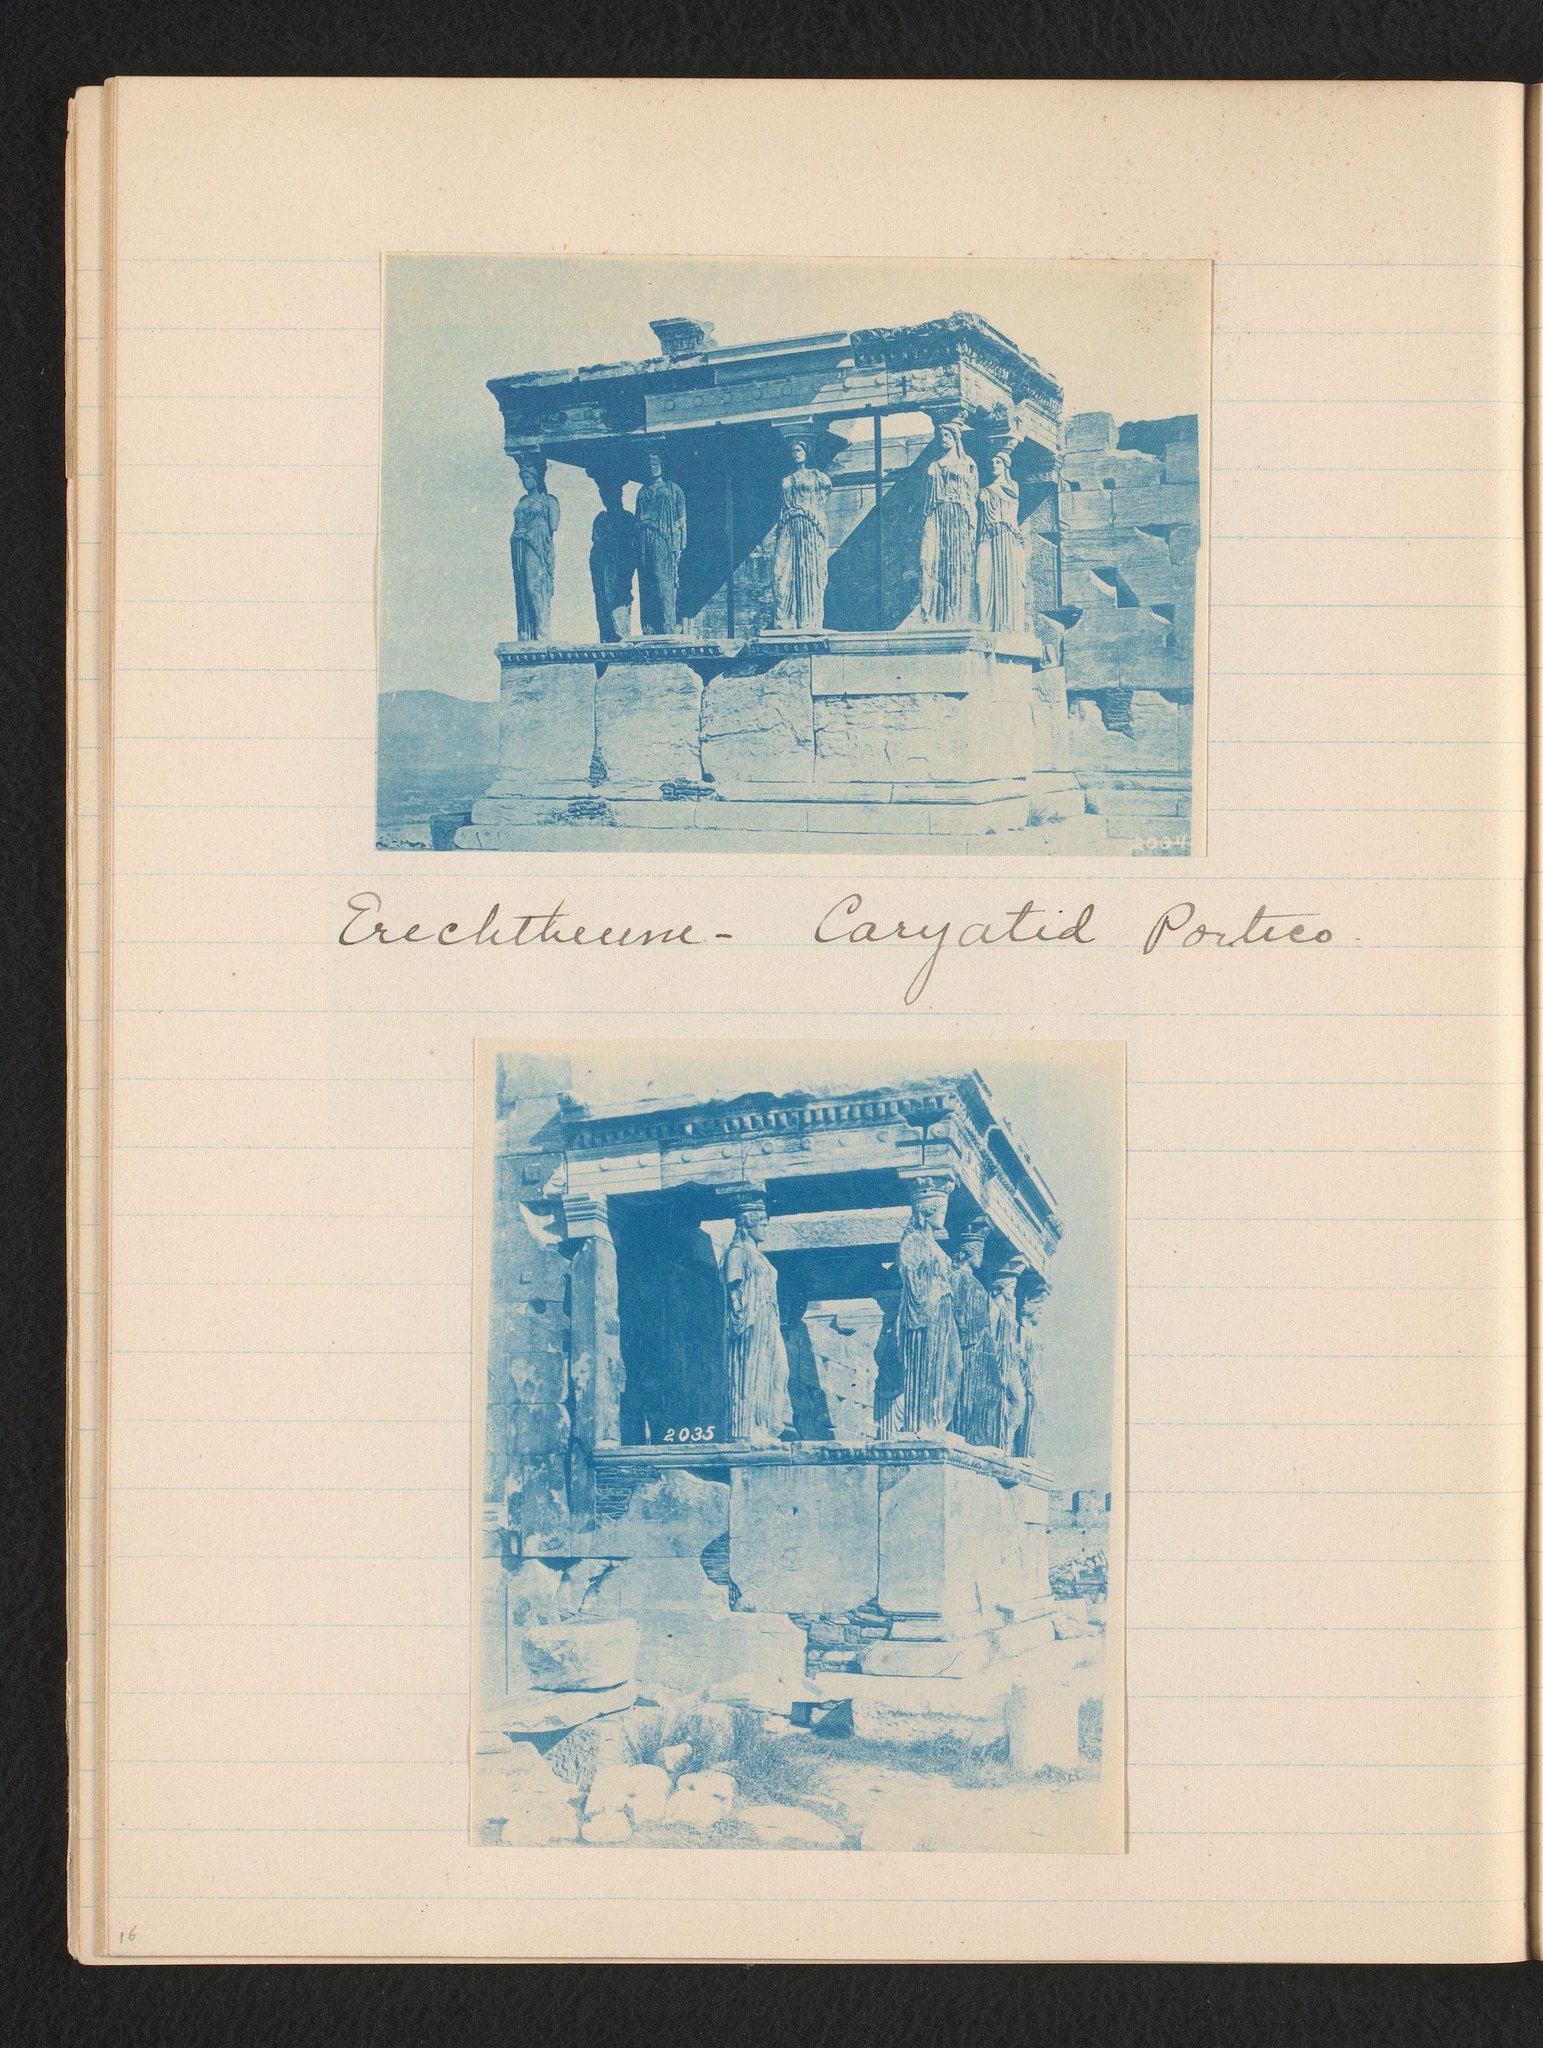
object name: album leaf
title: Erechteum - Caryatid Portico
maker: Anonymous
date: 1901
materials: paper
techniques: cyanotype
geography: athens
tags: caryatids ~ architecture, ruin of a building ~ architecture, temple, shrine ~ greek religion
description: Deze foto's maken deel uit van een album.